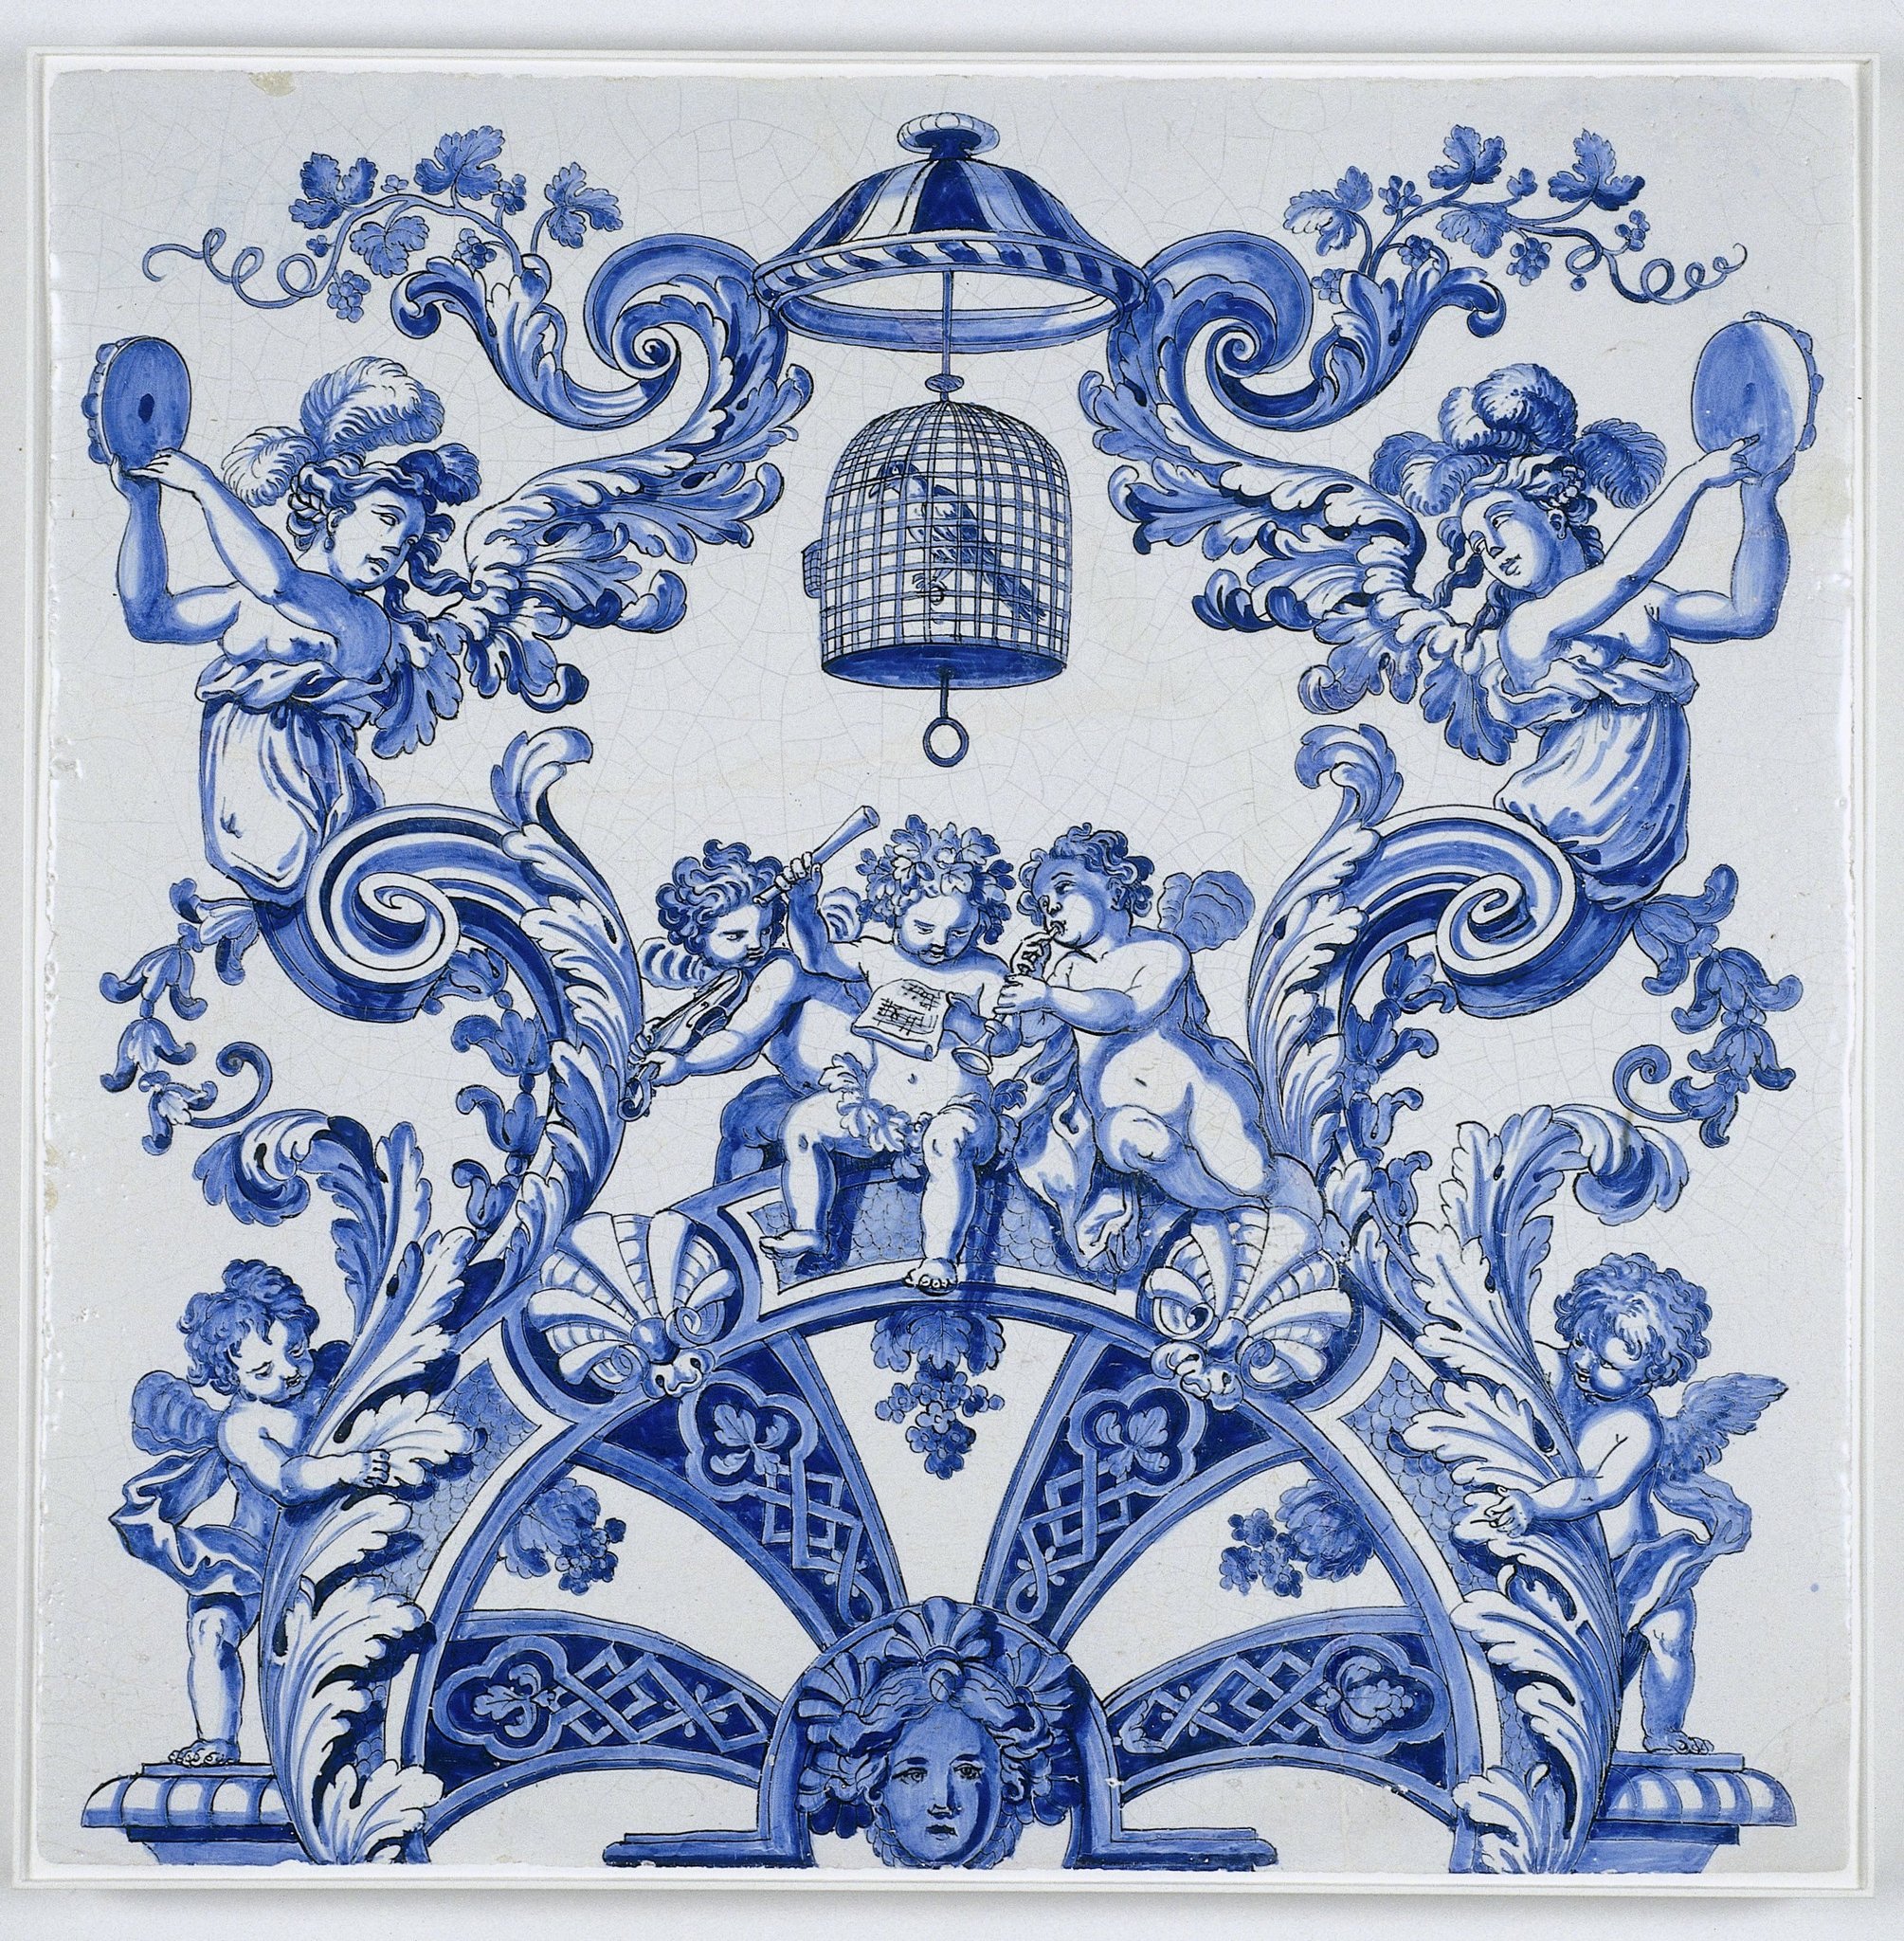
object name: tile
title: Three plaques from a column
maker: adrianus kocx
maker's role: plateelbakker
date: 1690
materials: earthenware, glaze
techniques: maiolica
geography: delft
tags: making music; musician with instrument, ornament derived from plant forms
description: The decoration on these plaques was based on designs by Daniël Marot, who may have played a pivotal role in furnishing and decorating the Water Gallery at Hampton Court Palace. The designs were not executed on the more usual smaller tiles, but on larger planes. Making such large plaques must have represented an enormous technical challenge. Each column was originally four or fourand- a-half plaques high.